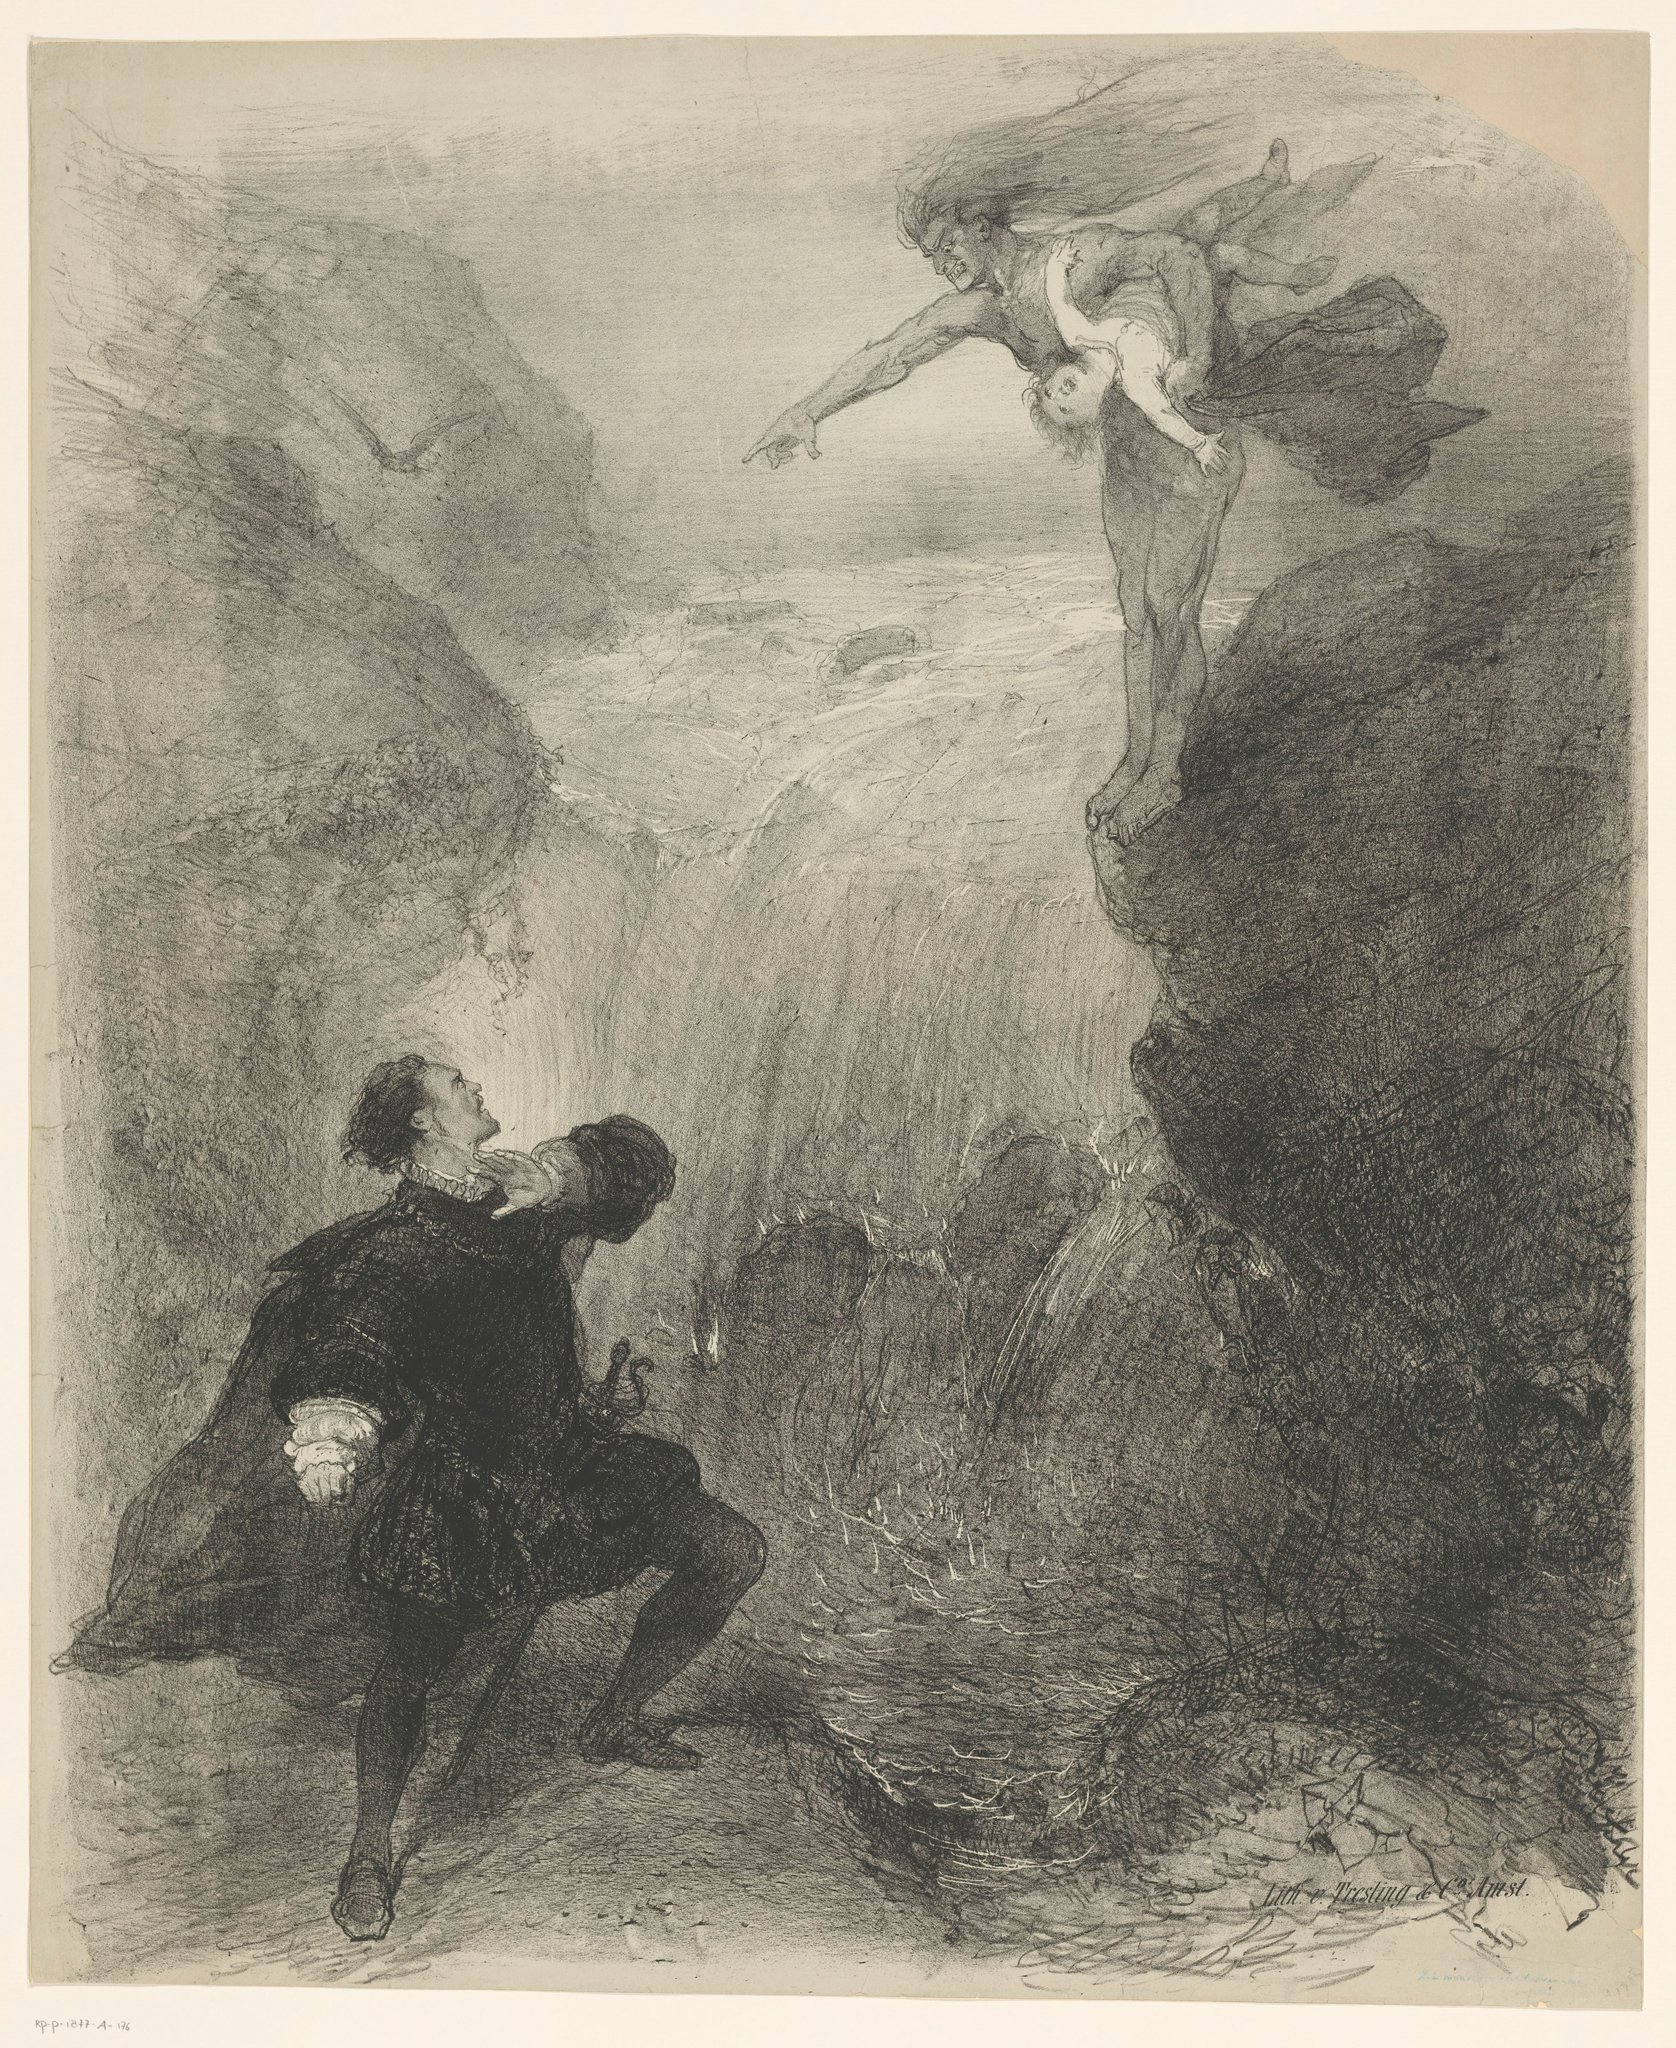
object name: print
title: Scene uit het ballet 'Het monster en de Toovenaar'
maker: charles rochussen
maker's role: draughtsman, painter, print maker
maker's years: 1814-1894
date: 1861-1862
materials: paper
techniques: lithograph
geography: amsterdam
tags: the ballet, ballet performance, sorcerer, magician, wizard, warlock, mis-shapen animals; monsters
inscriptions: collector's mark: Lugt 2228, inscription: ‘het monster en de toovenaar’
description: Een monster met een kind onder de arm staat op een rots rechts. Links een edelman van wie het kind ontroofd schijnt te zijn.